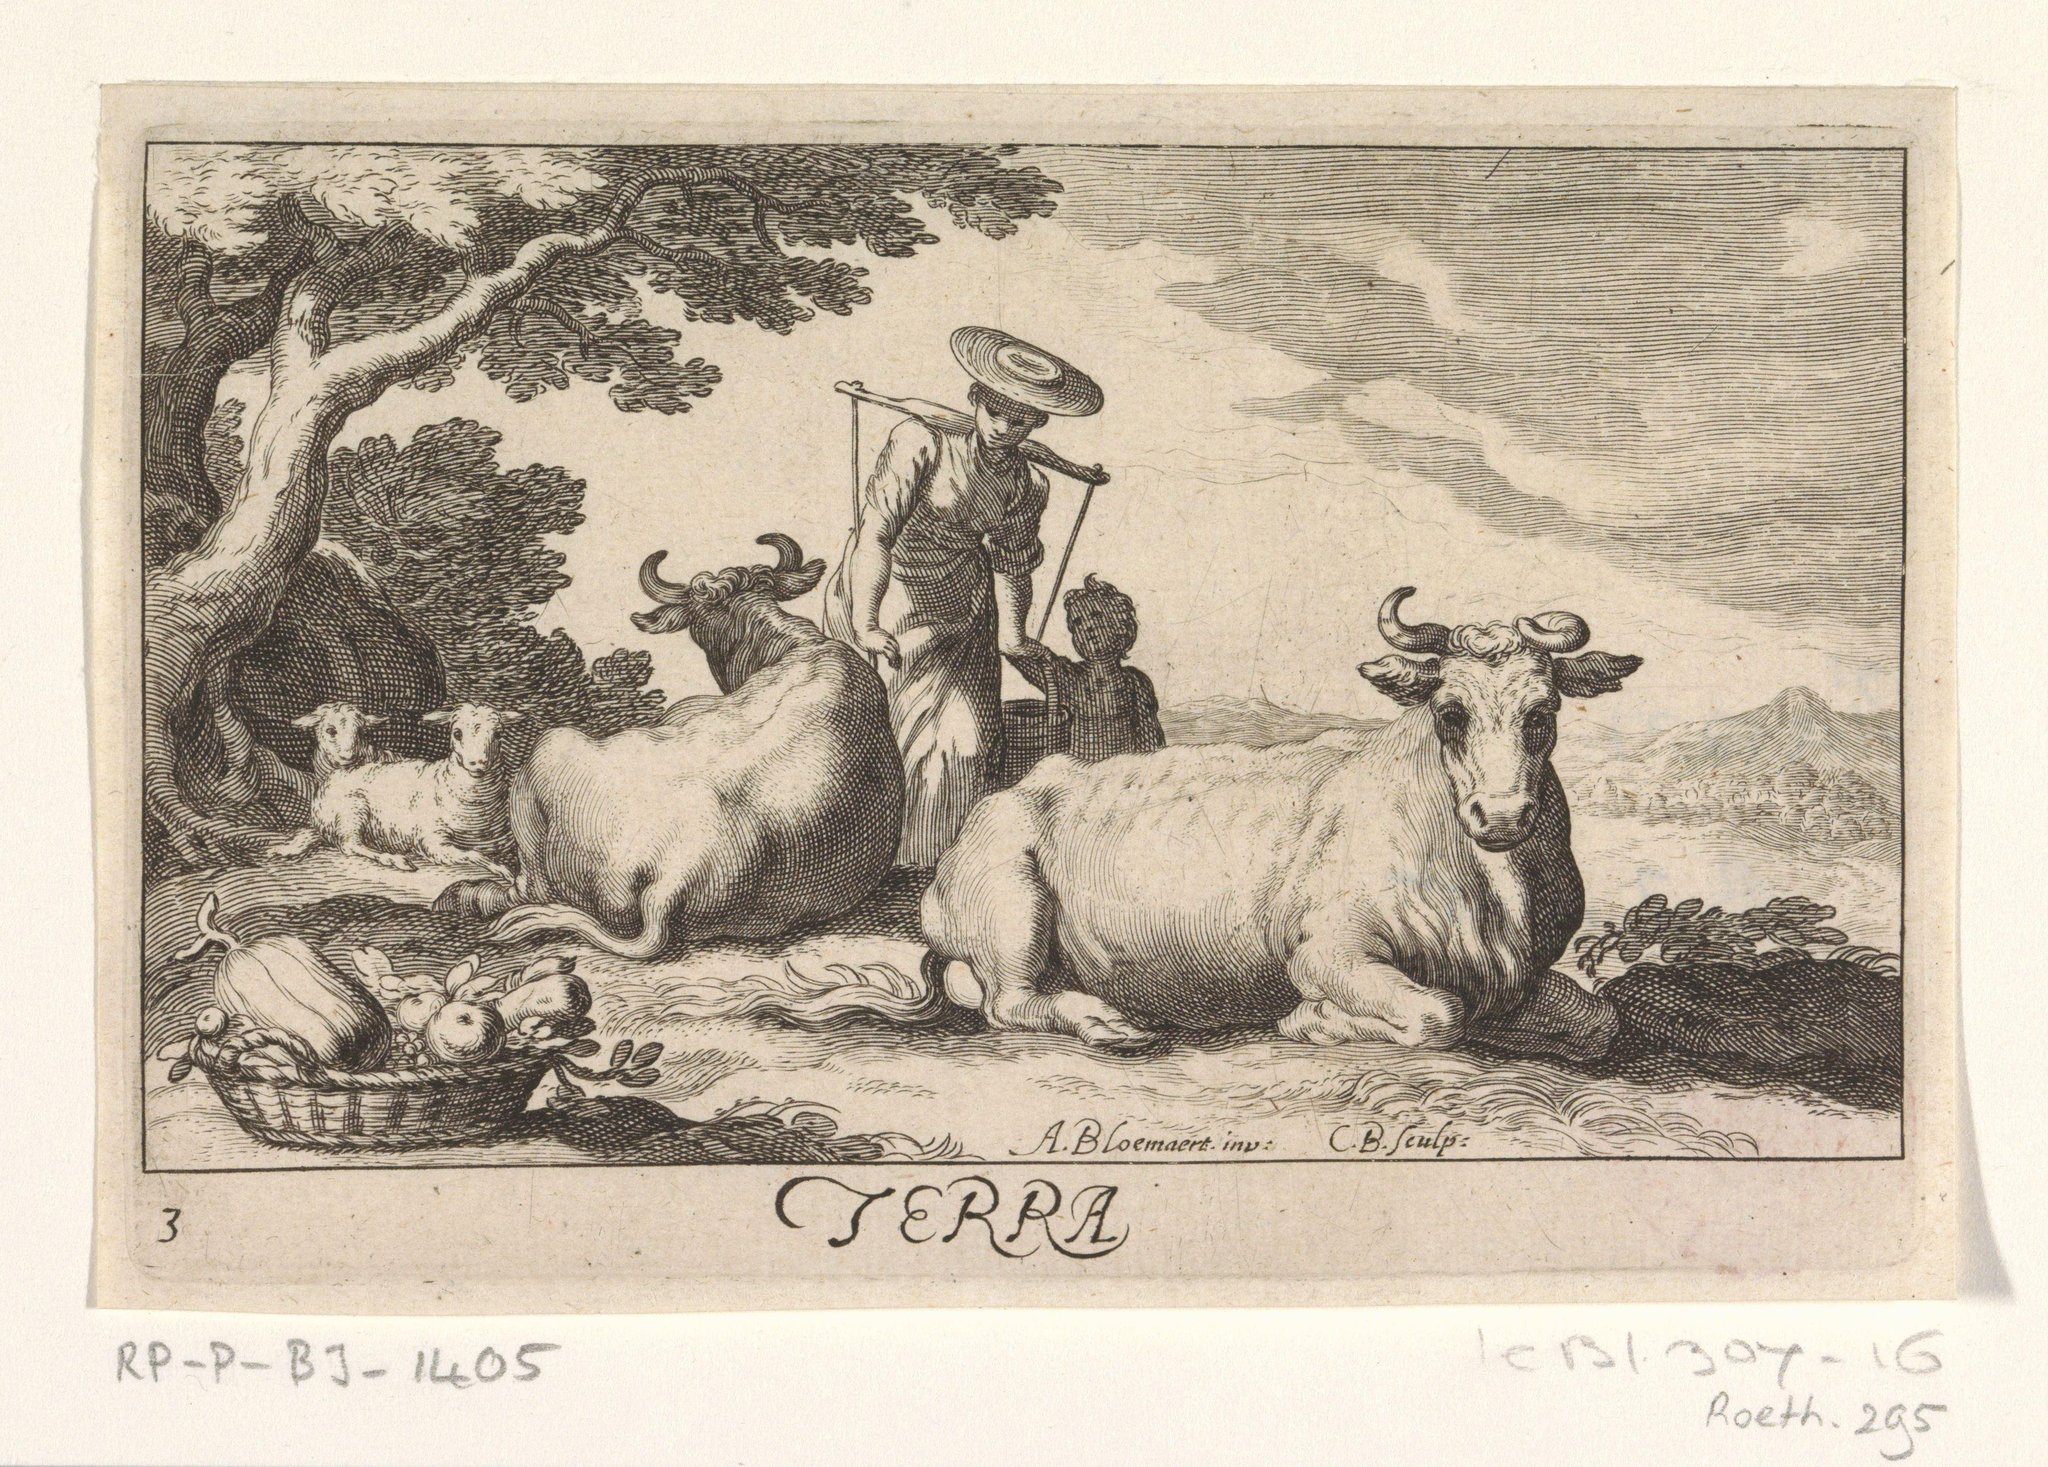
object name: print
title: Terra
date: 1620-1630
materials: paper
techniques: engraving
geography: utrecht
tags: earth (one of the four elements)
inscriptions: collector's mark: Lugt 240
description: Een vrouw met een juk op de schouders en een kind aan de hand, beweegt zich tussen de koeien. Op de voorgrond een mand met groenten en fruit.